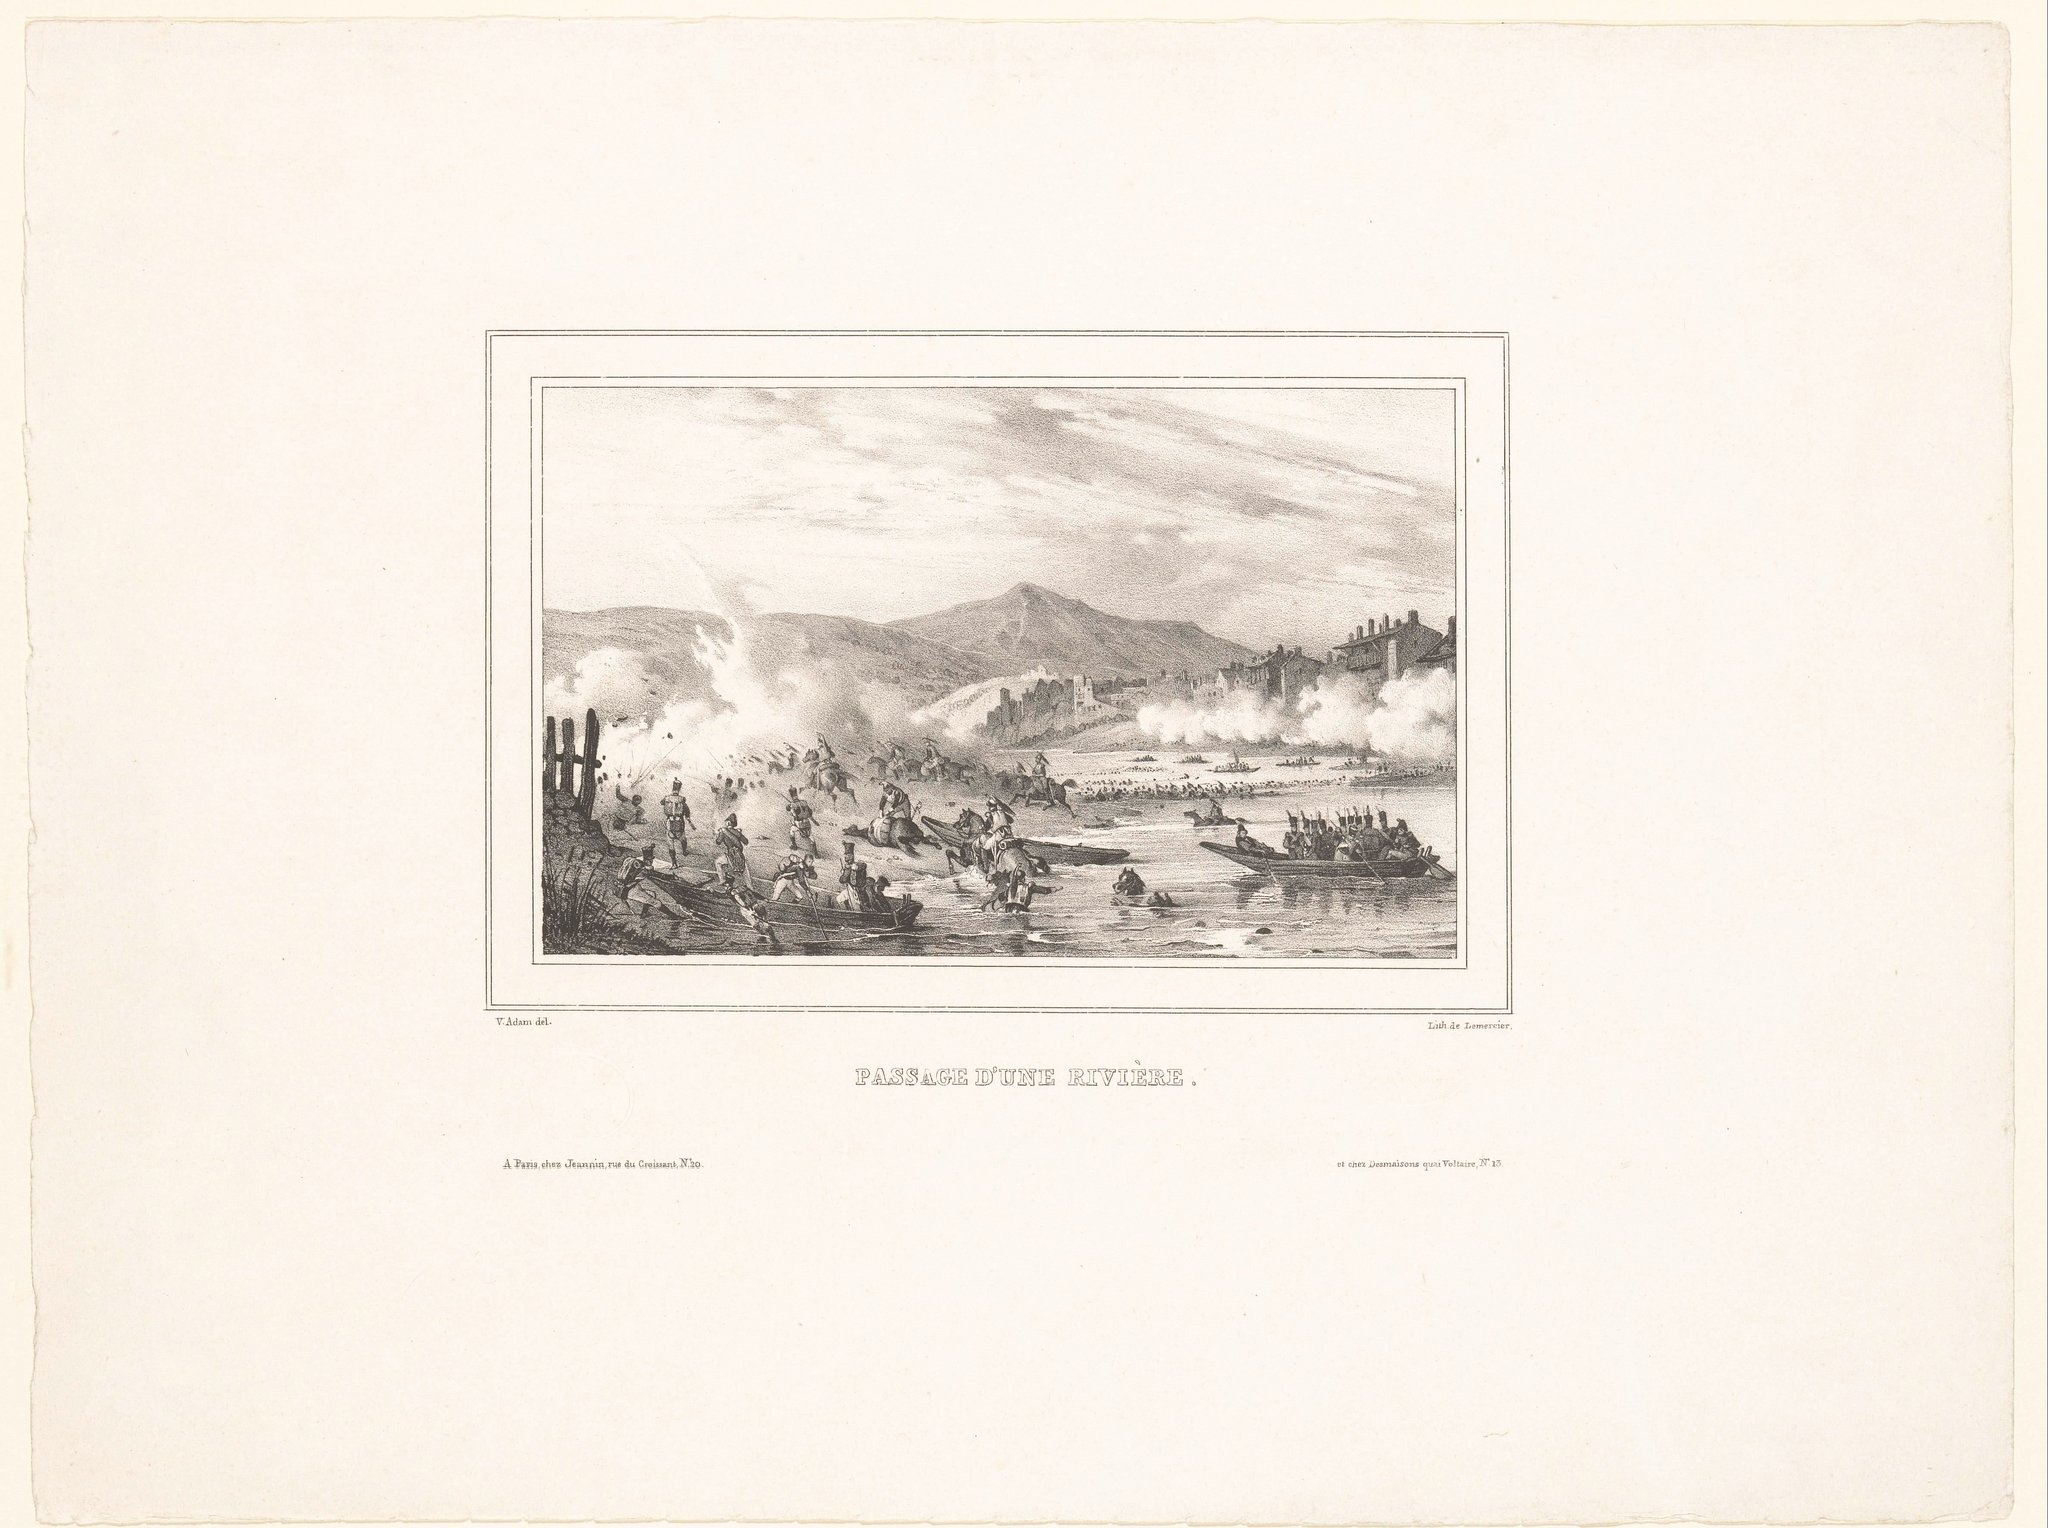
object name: print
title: Oversteek van een rivier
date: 1832-1835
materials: paper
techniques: lithograph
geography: paris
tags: crossing a river, battle (+ warfare ~ water, along a river, on a shore)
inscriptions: check stamp: ‘E.D.’, check stamp: Lugt 3987, collector's mark: Lugt 2228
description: Tijdens een gevecht steken Franse soldaten te paard en in boten een rivier over. Op de achtergrond kruitdampen, bergen en een stad.